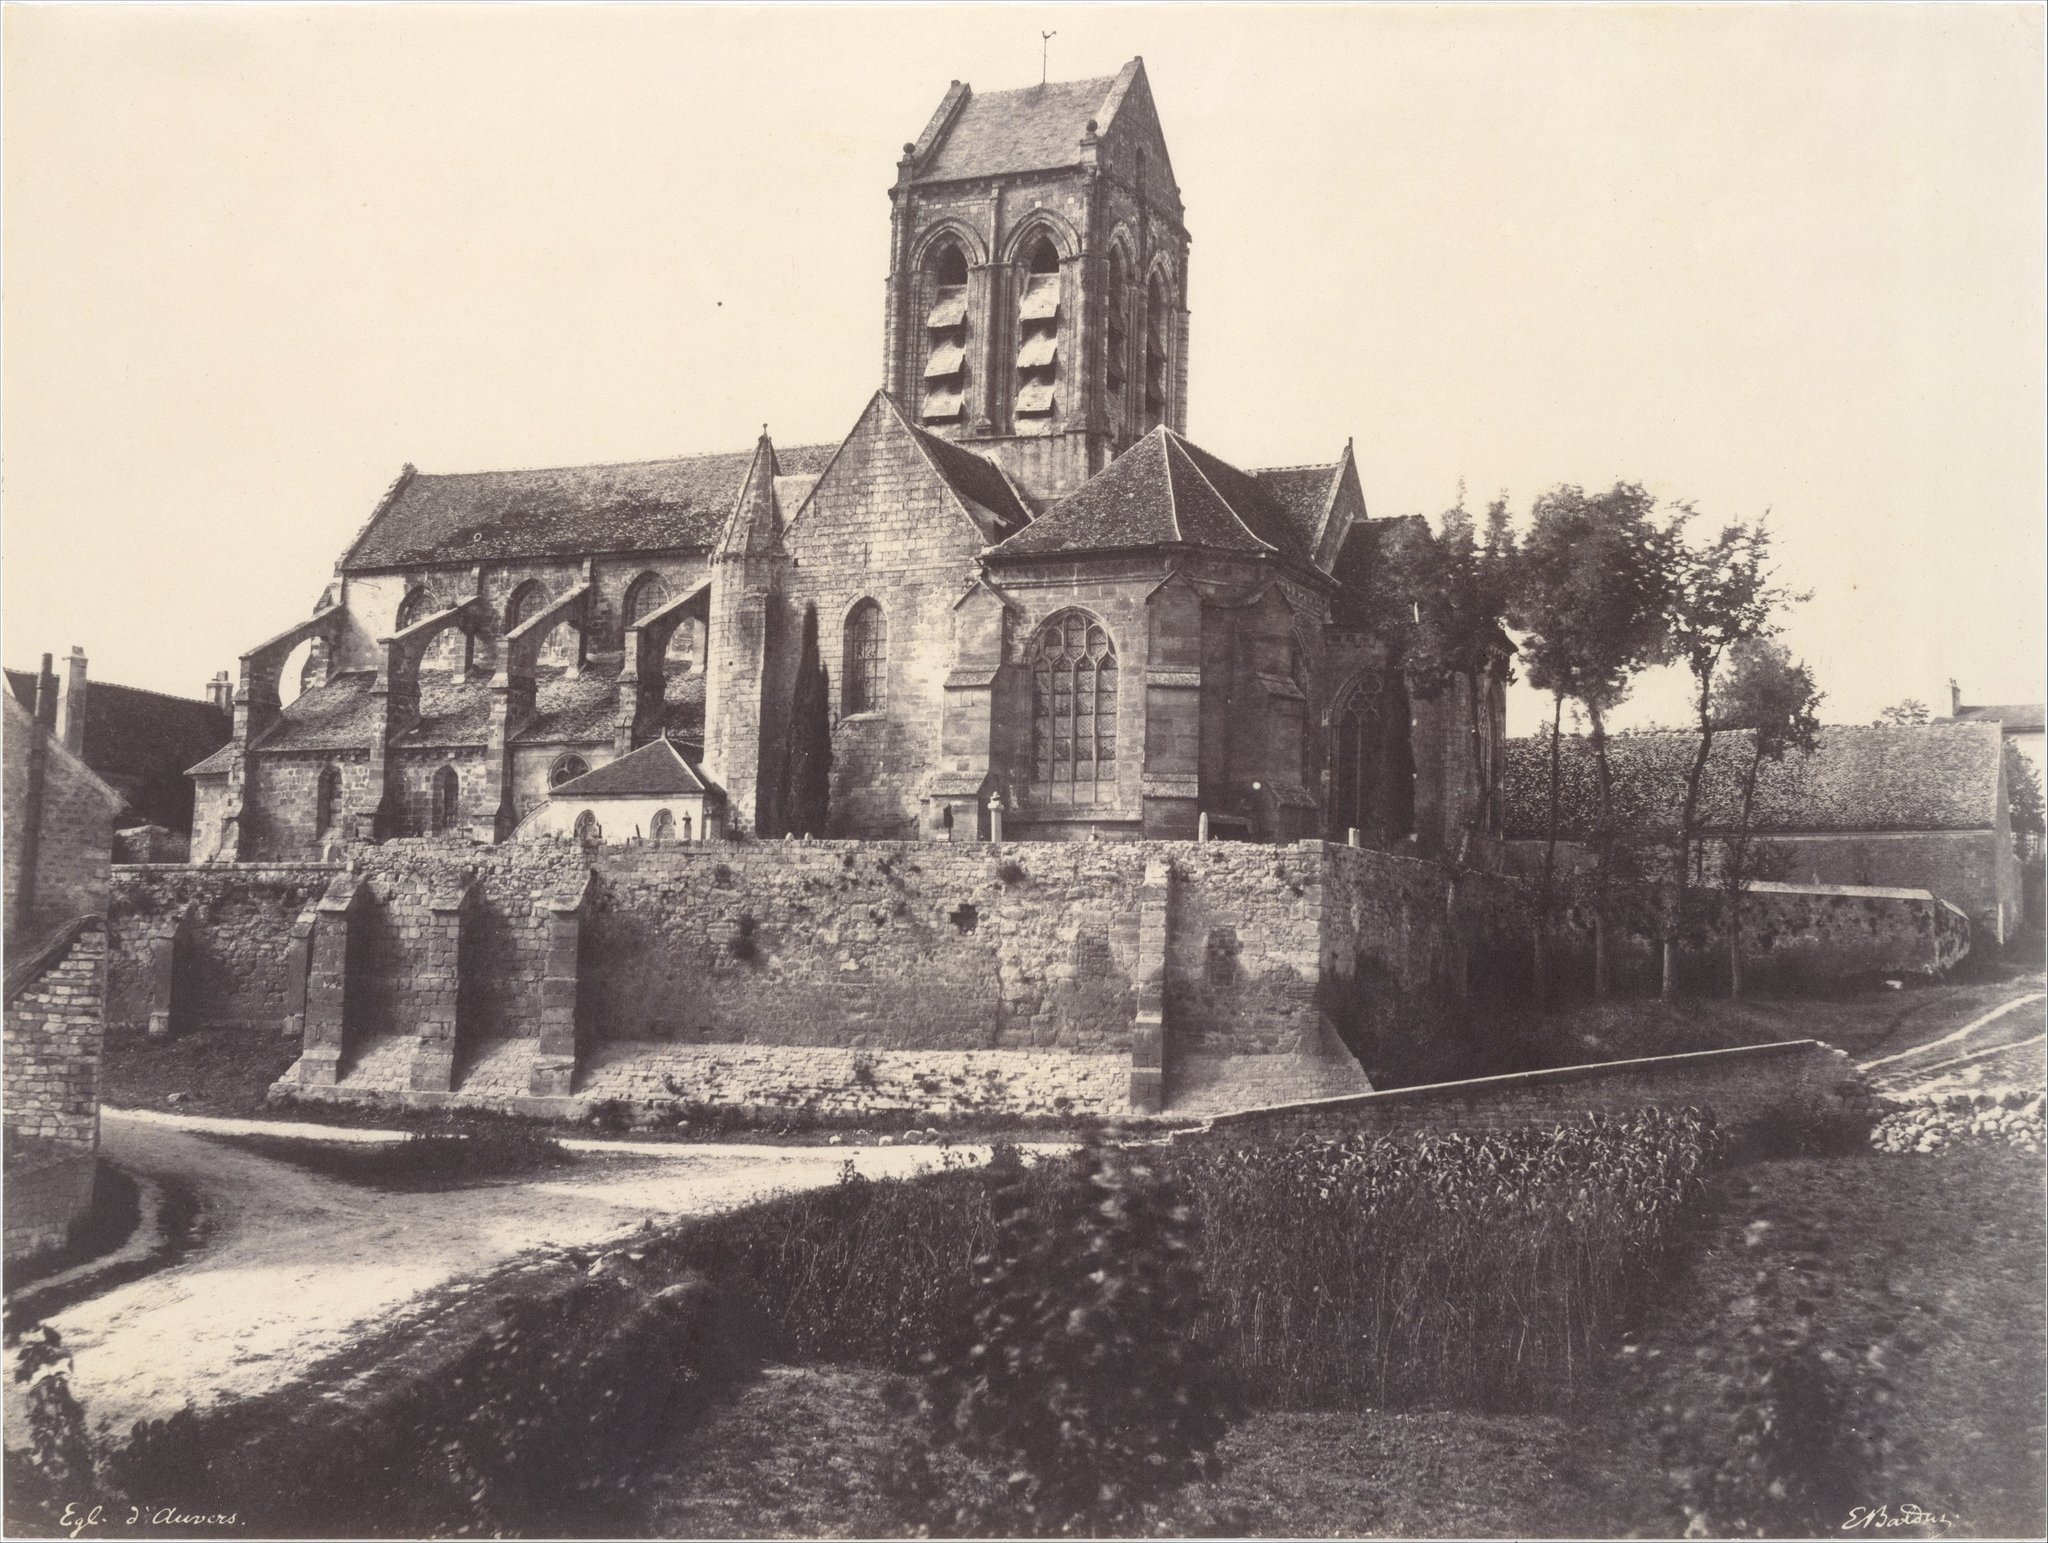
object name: photograph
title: Eglise d'Auvers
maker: édouard denis baldus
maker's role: fotograaf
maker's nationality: french, born prussia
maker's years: 1813-1889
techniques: paper negative, salted paper print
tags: architecture,churches